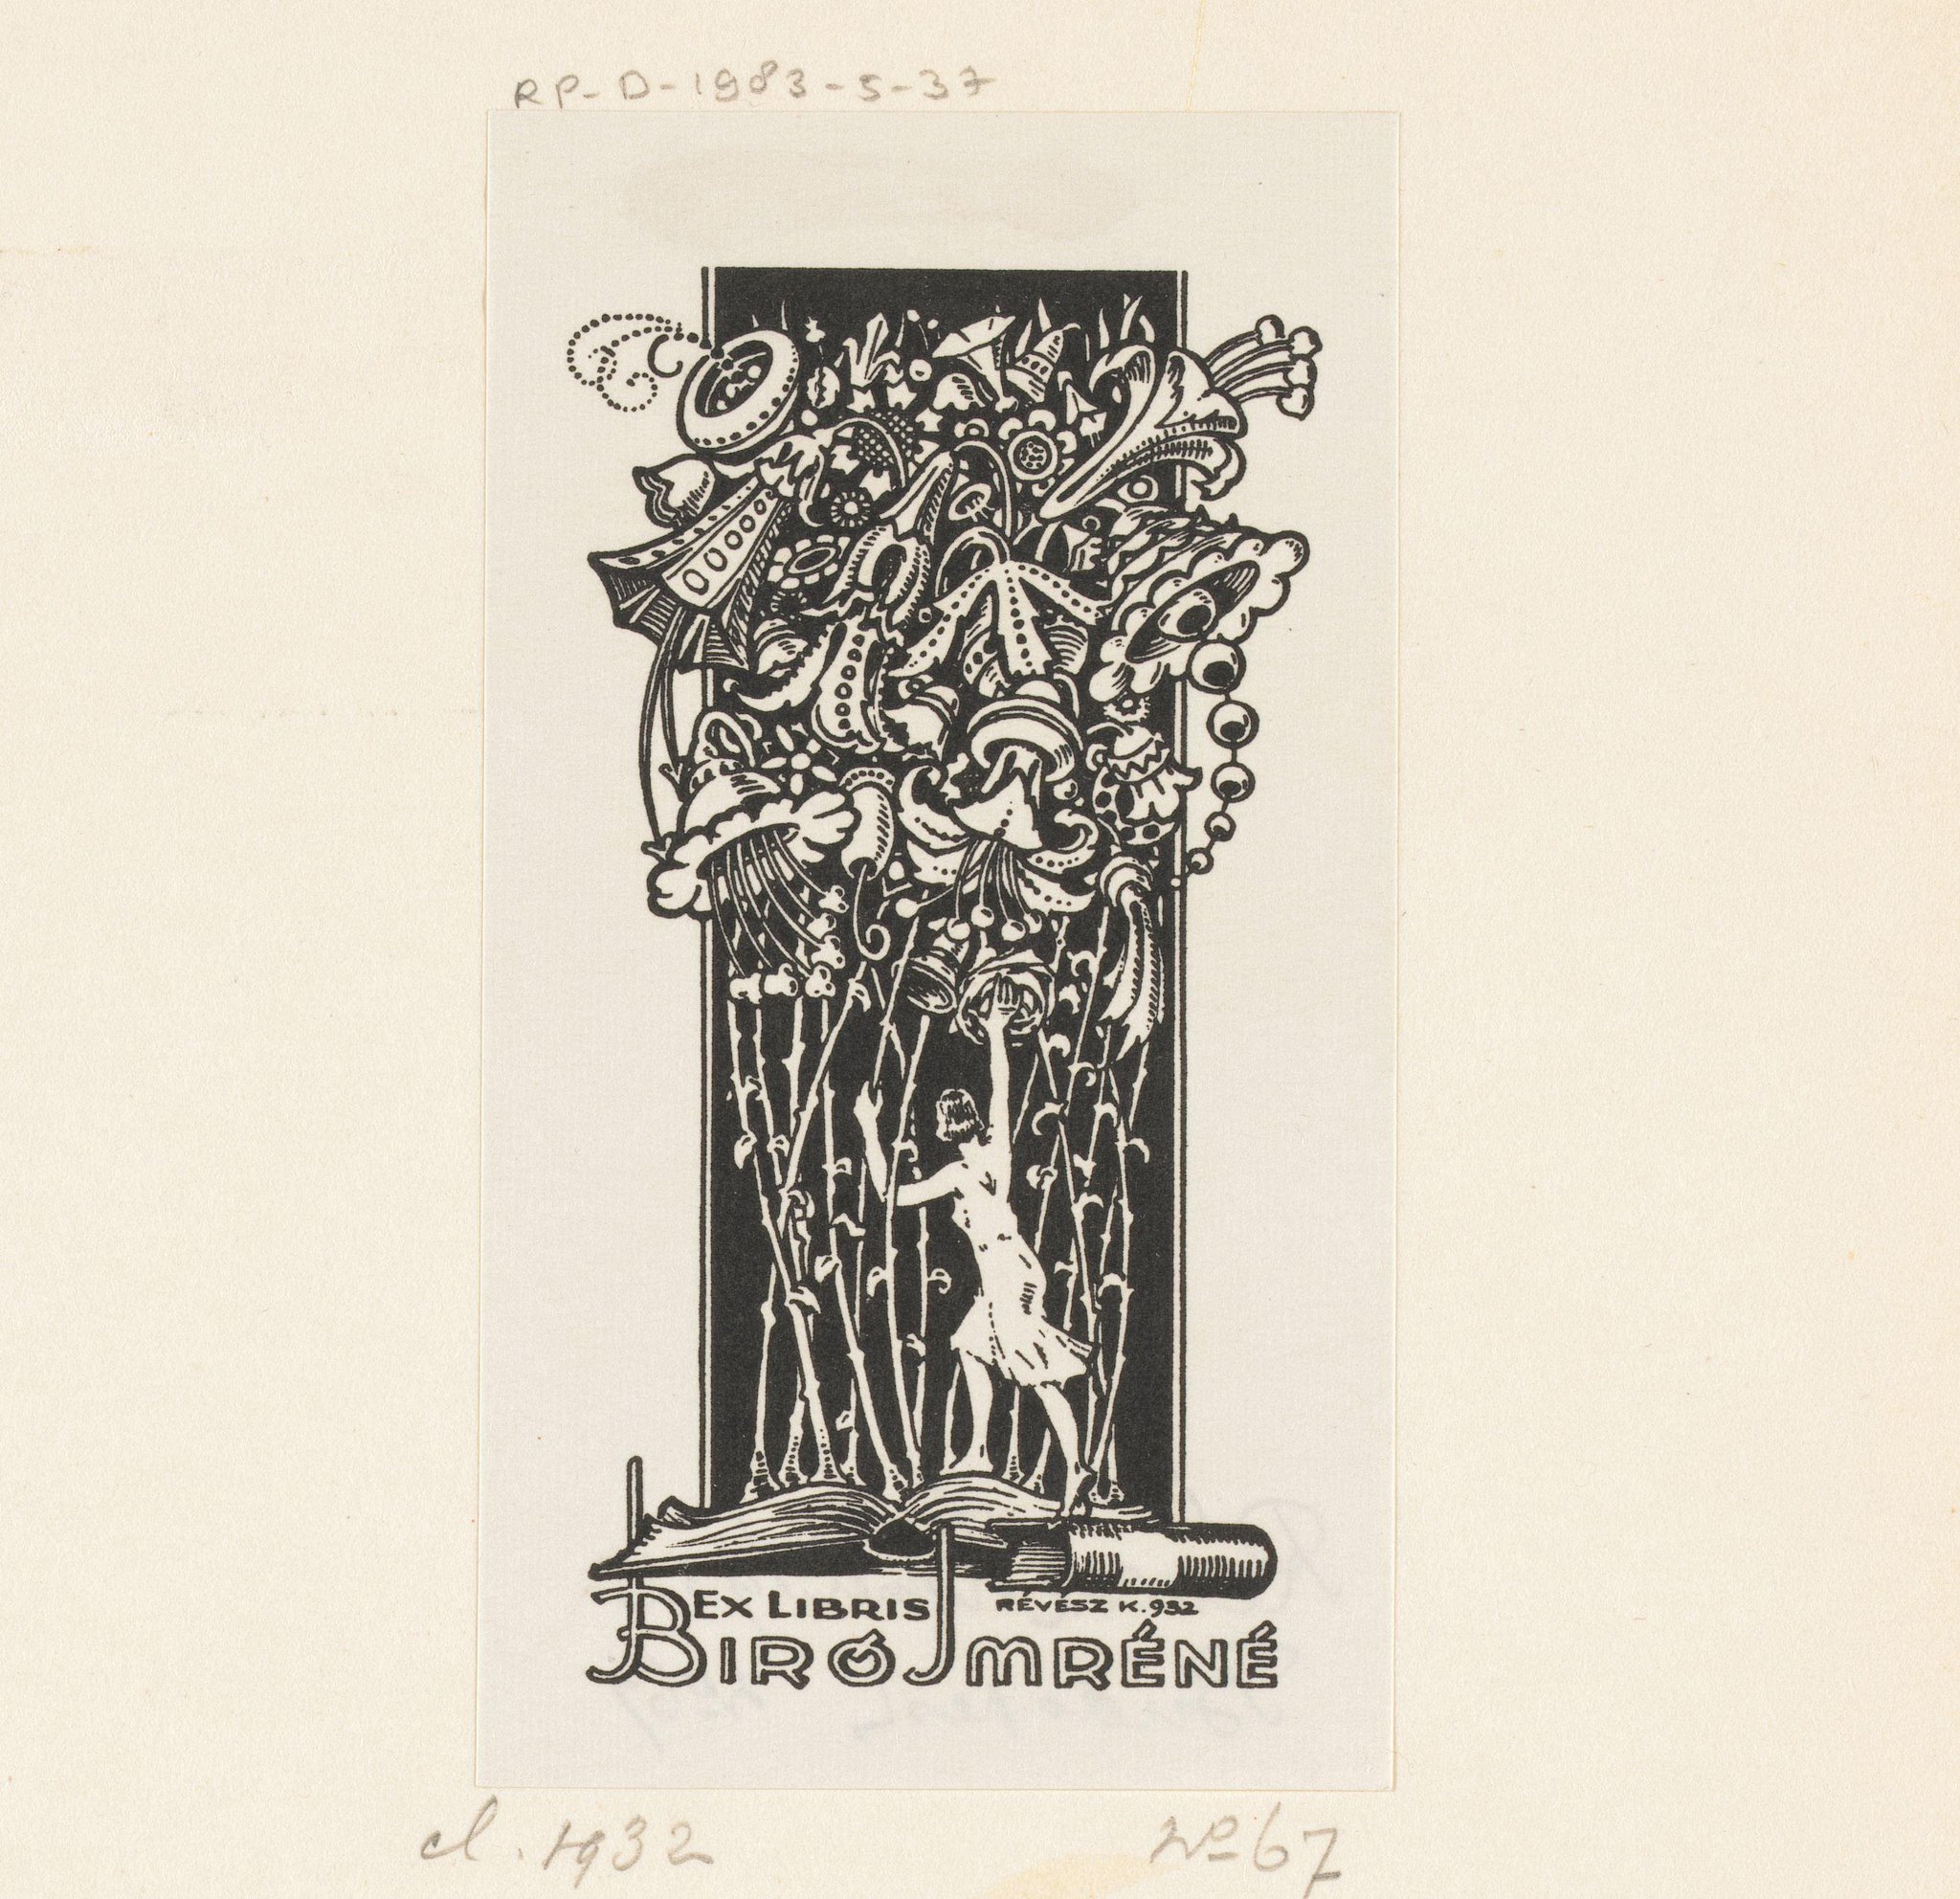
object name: bookplate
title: Ex libris van Imréné Biró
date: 1932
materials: paper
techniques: printing block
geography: budapest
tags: fantastic plants, fabulous vegetation, book, standing figure - aa - female human figure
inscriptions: date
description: Ex libris maakt deel uit van omslag met 64 ex libris op 34 losse opzetvellen, een catalogus en een tekstblad.